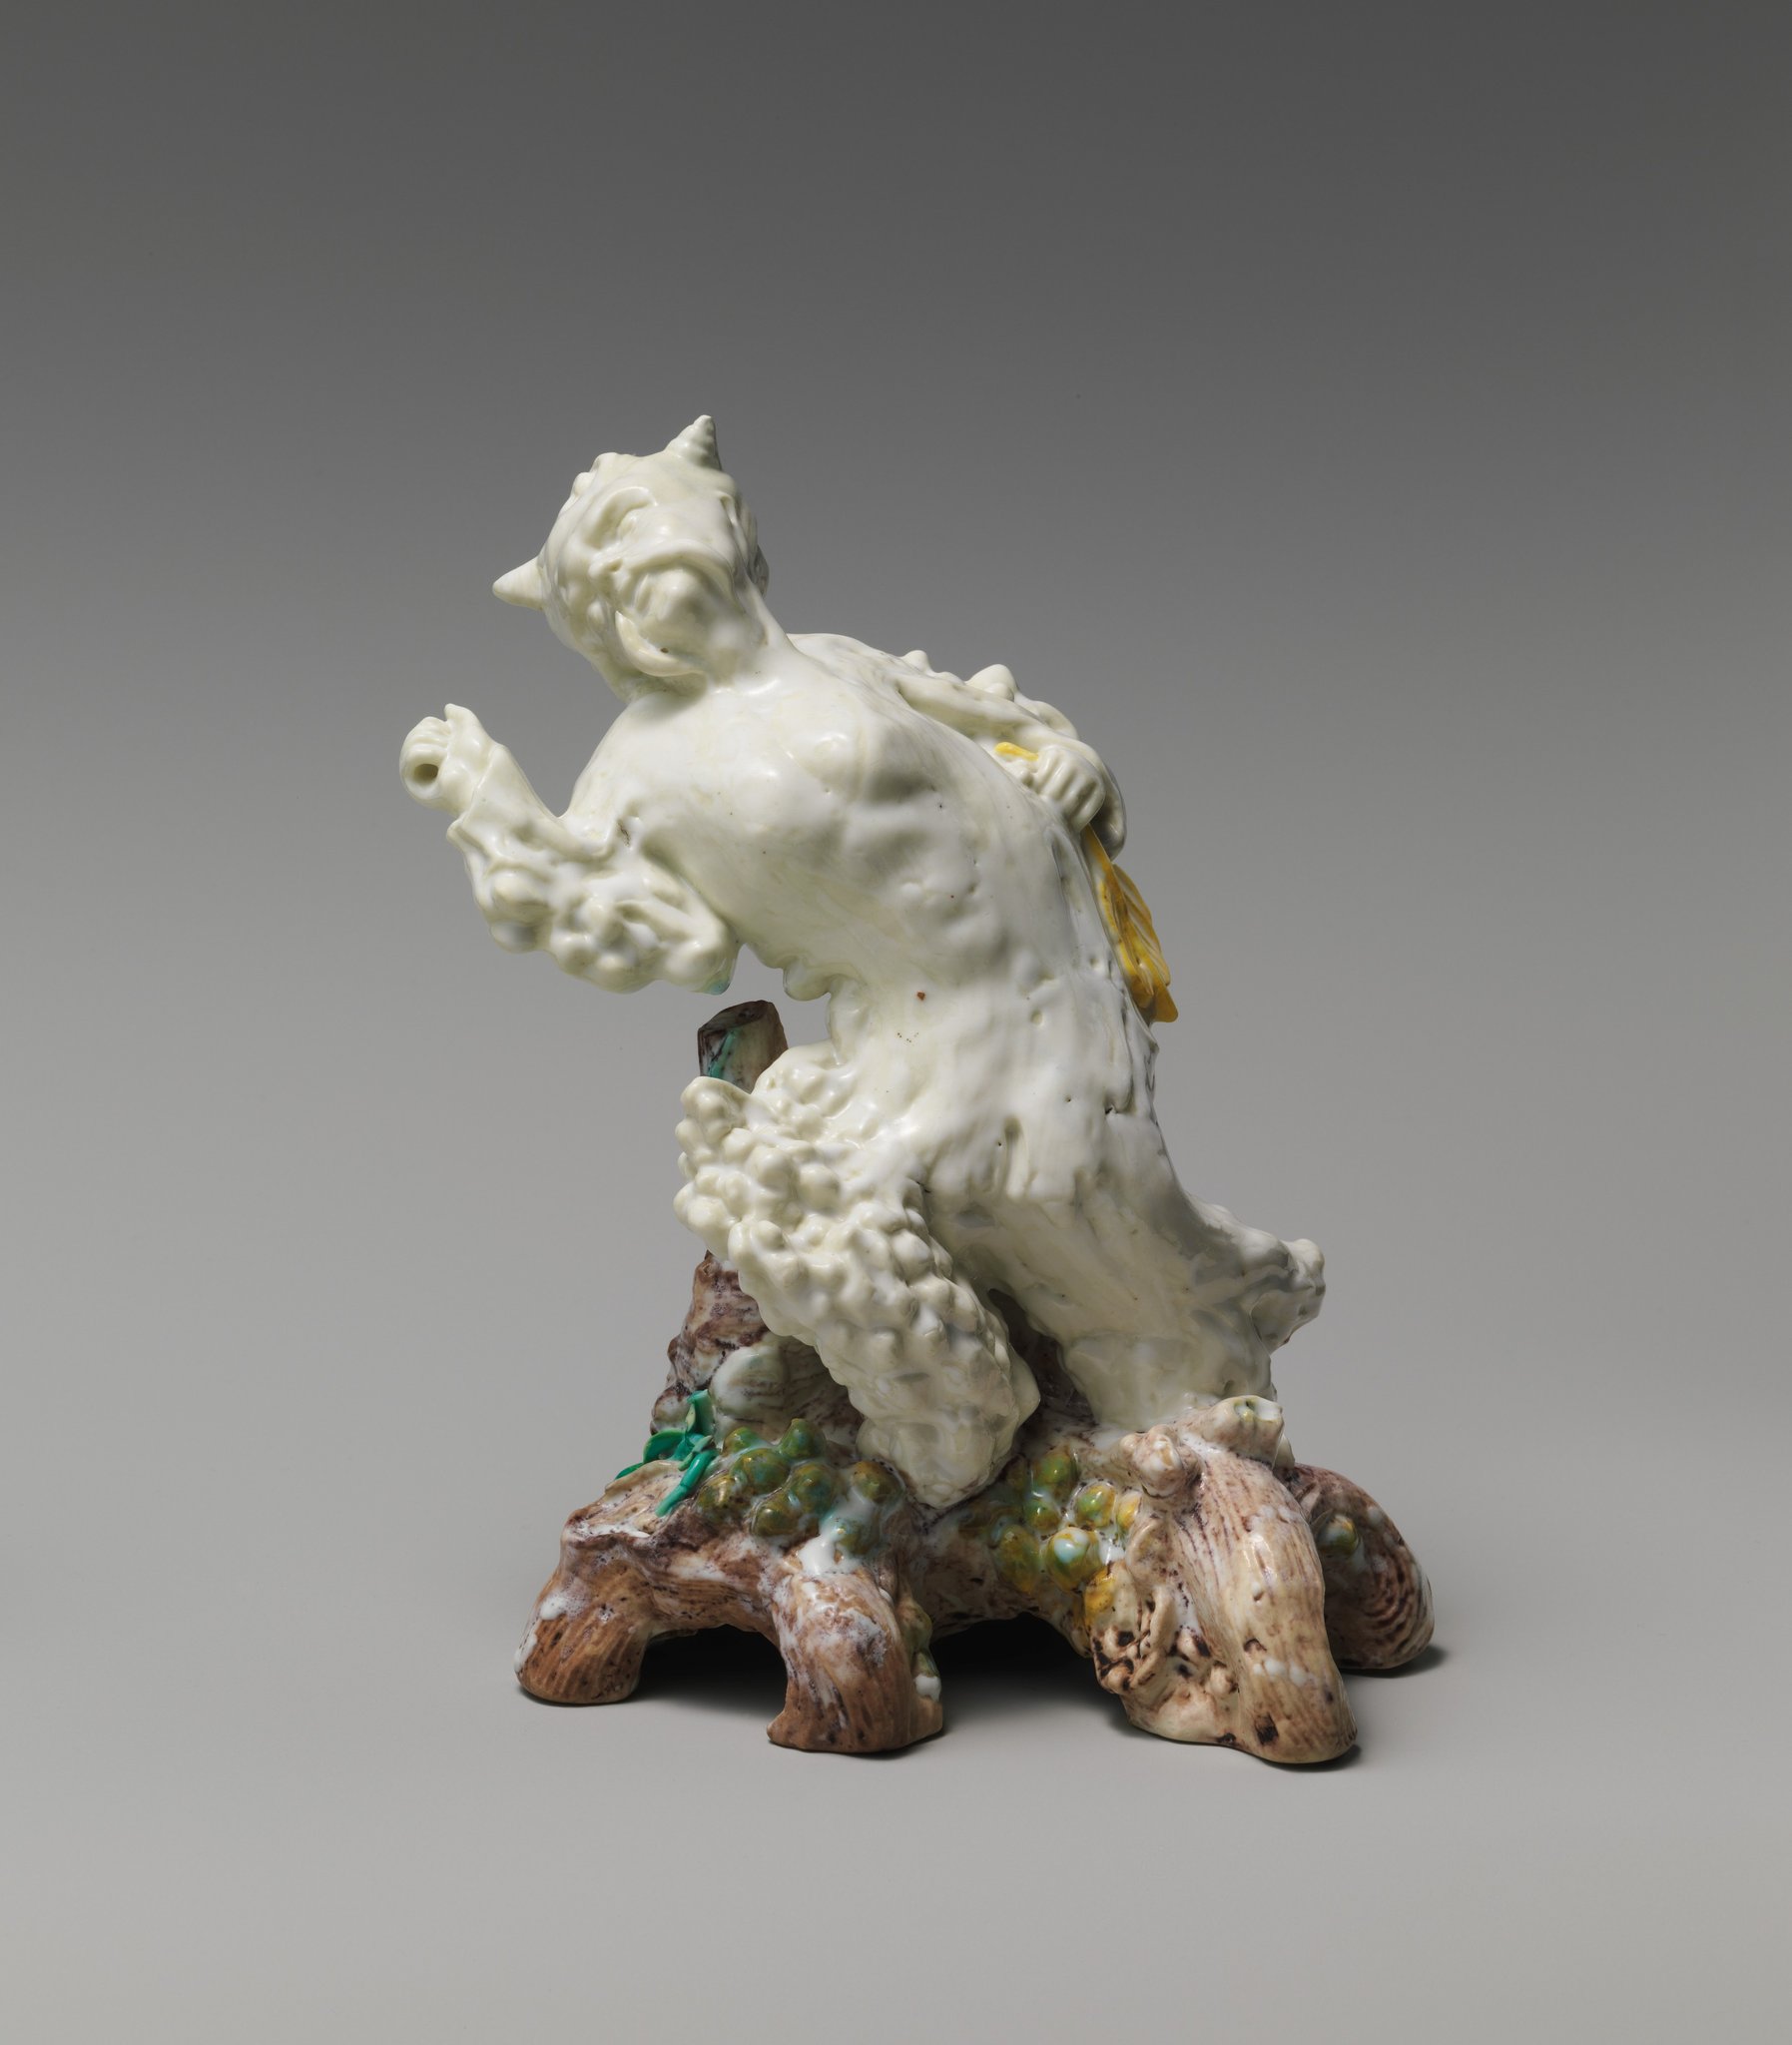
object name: figure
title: Satyr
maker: villeroy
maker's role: factory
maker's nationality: french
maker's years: 1734-1748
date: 1740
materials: soft paste porcelain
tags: satyrs